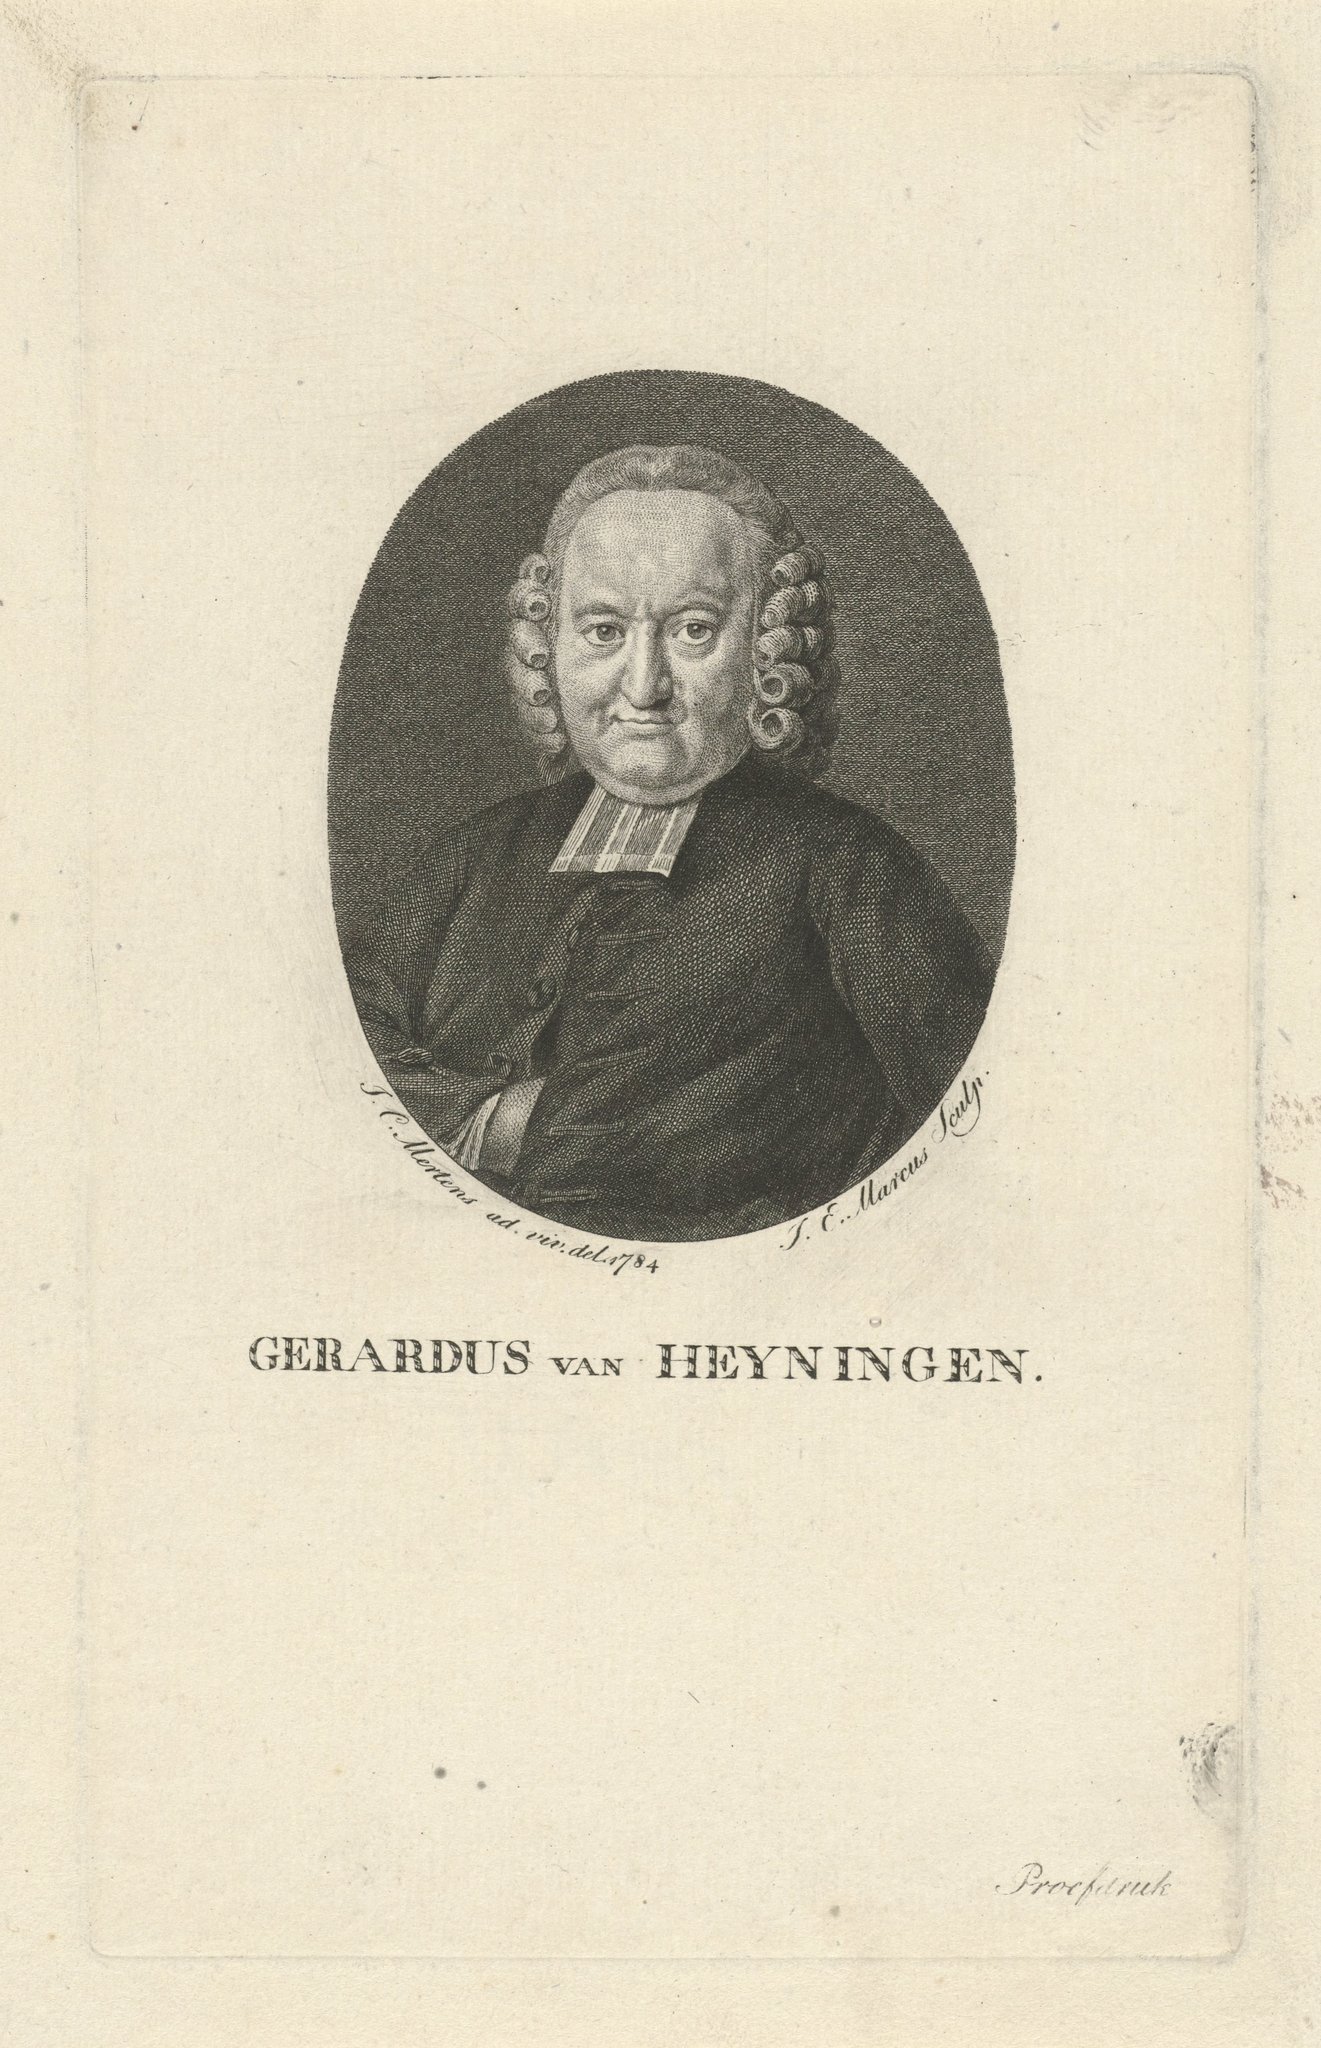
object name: print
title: Portret van Gerardus van Heyningen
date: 1784-1826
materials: paper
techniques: etching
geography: amsterdam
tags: amsterdam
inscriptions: collector's mark: Lugt 2228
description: Portret van de predikant Gerardus van Heyningen. Rechtsonder gemerkt: Proefdruk.